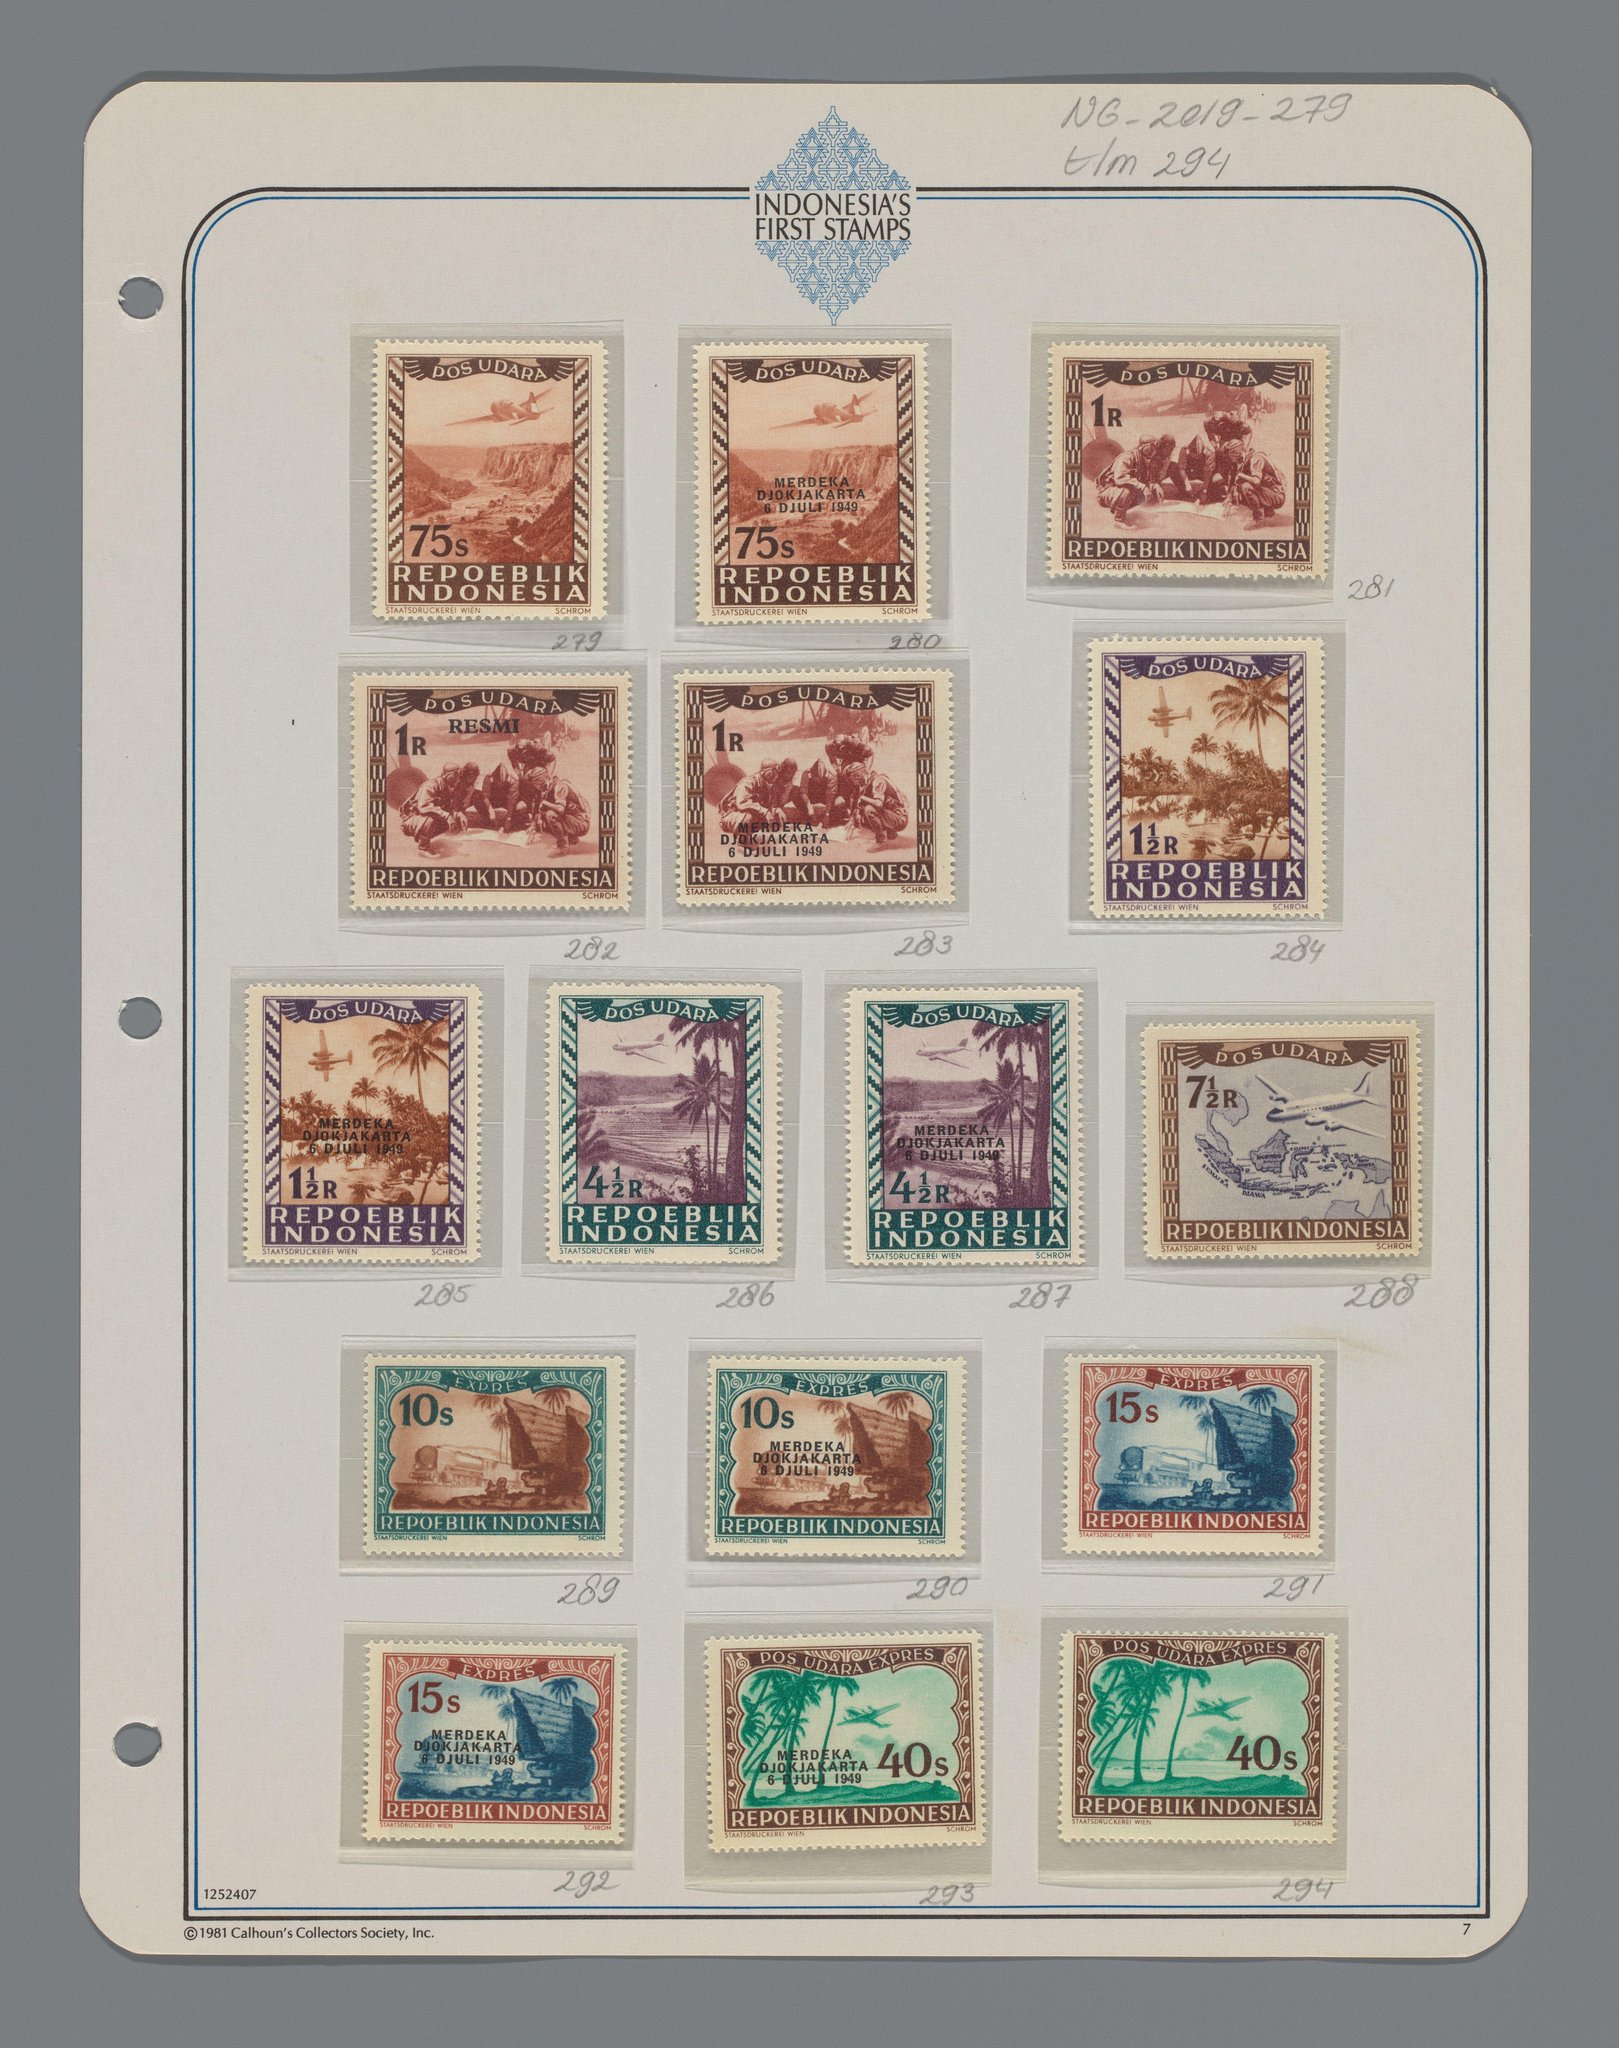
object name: postage stamp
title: Postzegel Republik Indonesia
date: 1949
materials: paper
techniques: photoaquatint, engraving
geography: philadelphia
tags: indonesia